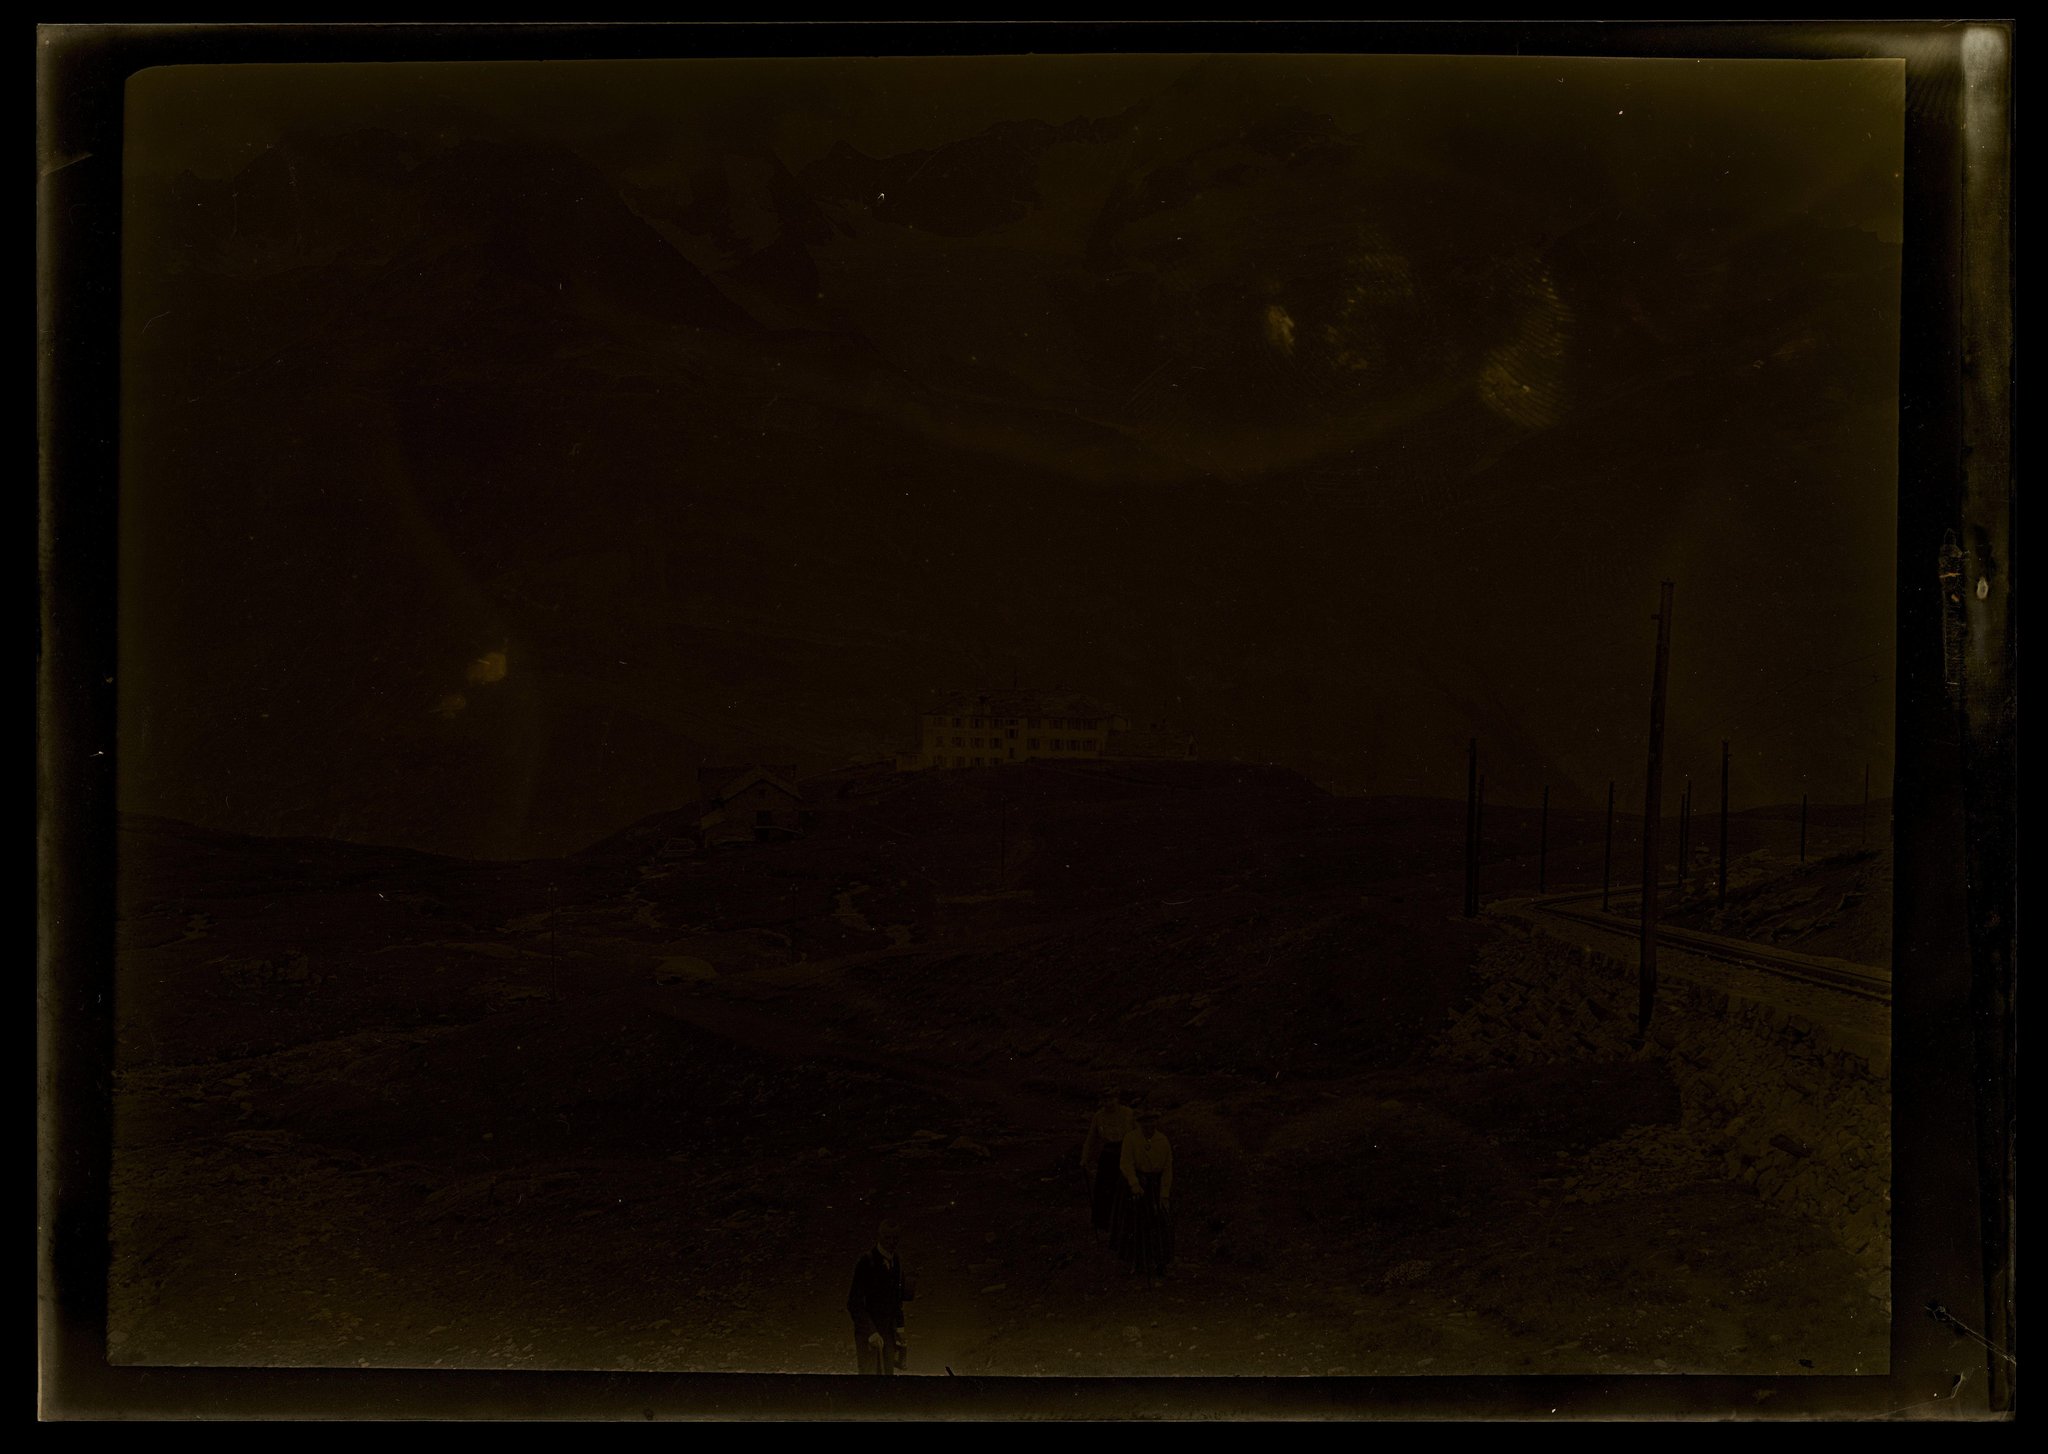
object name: negative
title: Filmnegatief met opname van Zermatt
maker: Anonymous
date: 1921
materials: film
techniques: gelatin silver negative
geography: zermatt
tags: zermatt